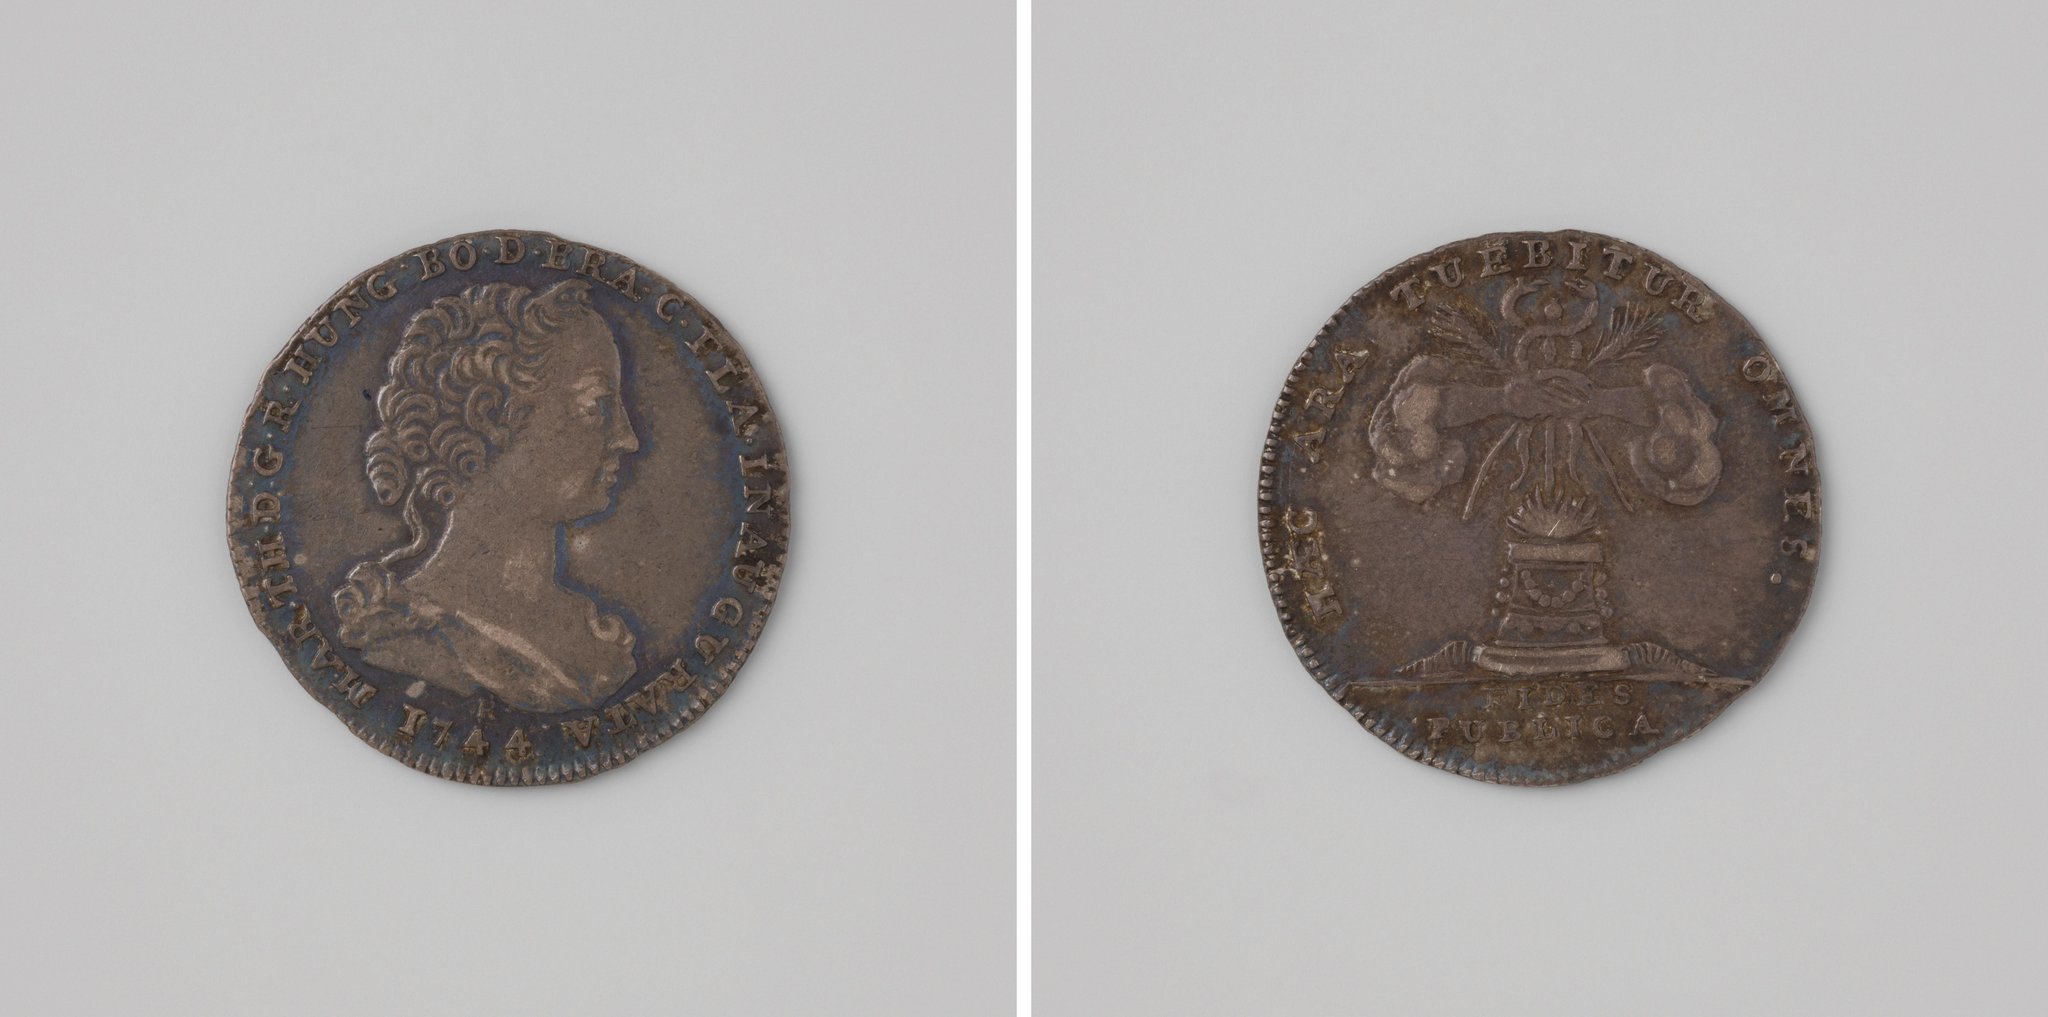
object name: jeton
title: Inhuldiging van Maria Theresia als gravin van Brabant en Vlaanderen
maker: jacques roëttiers (ii)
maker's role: medailleur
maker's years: 1698-1772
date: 1744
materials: silver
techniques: striking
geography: antwerp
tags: vienna, maria theresia (rooms-duits keizerin), brabant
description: Zilveren penning. Voorzijde: borststuk vrouw met diadeem binnen omschrift. Keerzijde: twee ineengeslagen handen uit wolken houden Mercuriusstaf en twee korenaren boven brandend altaar binnen omschrift; afsnede: opschrift